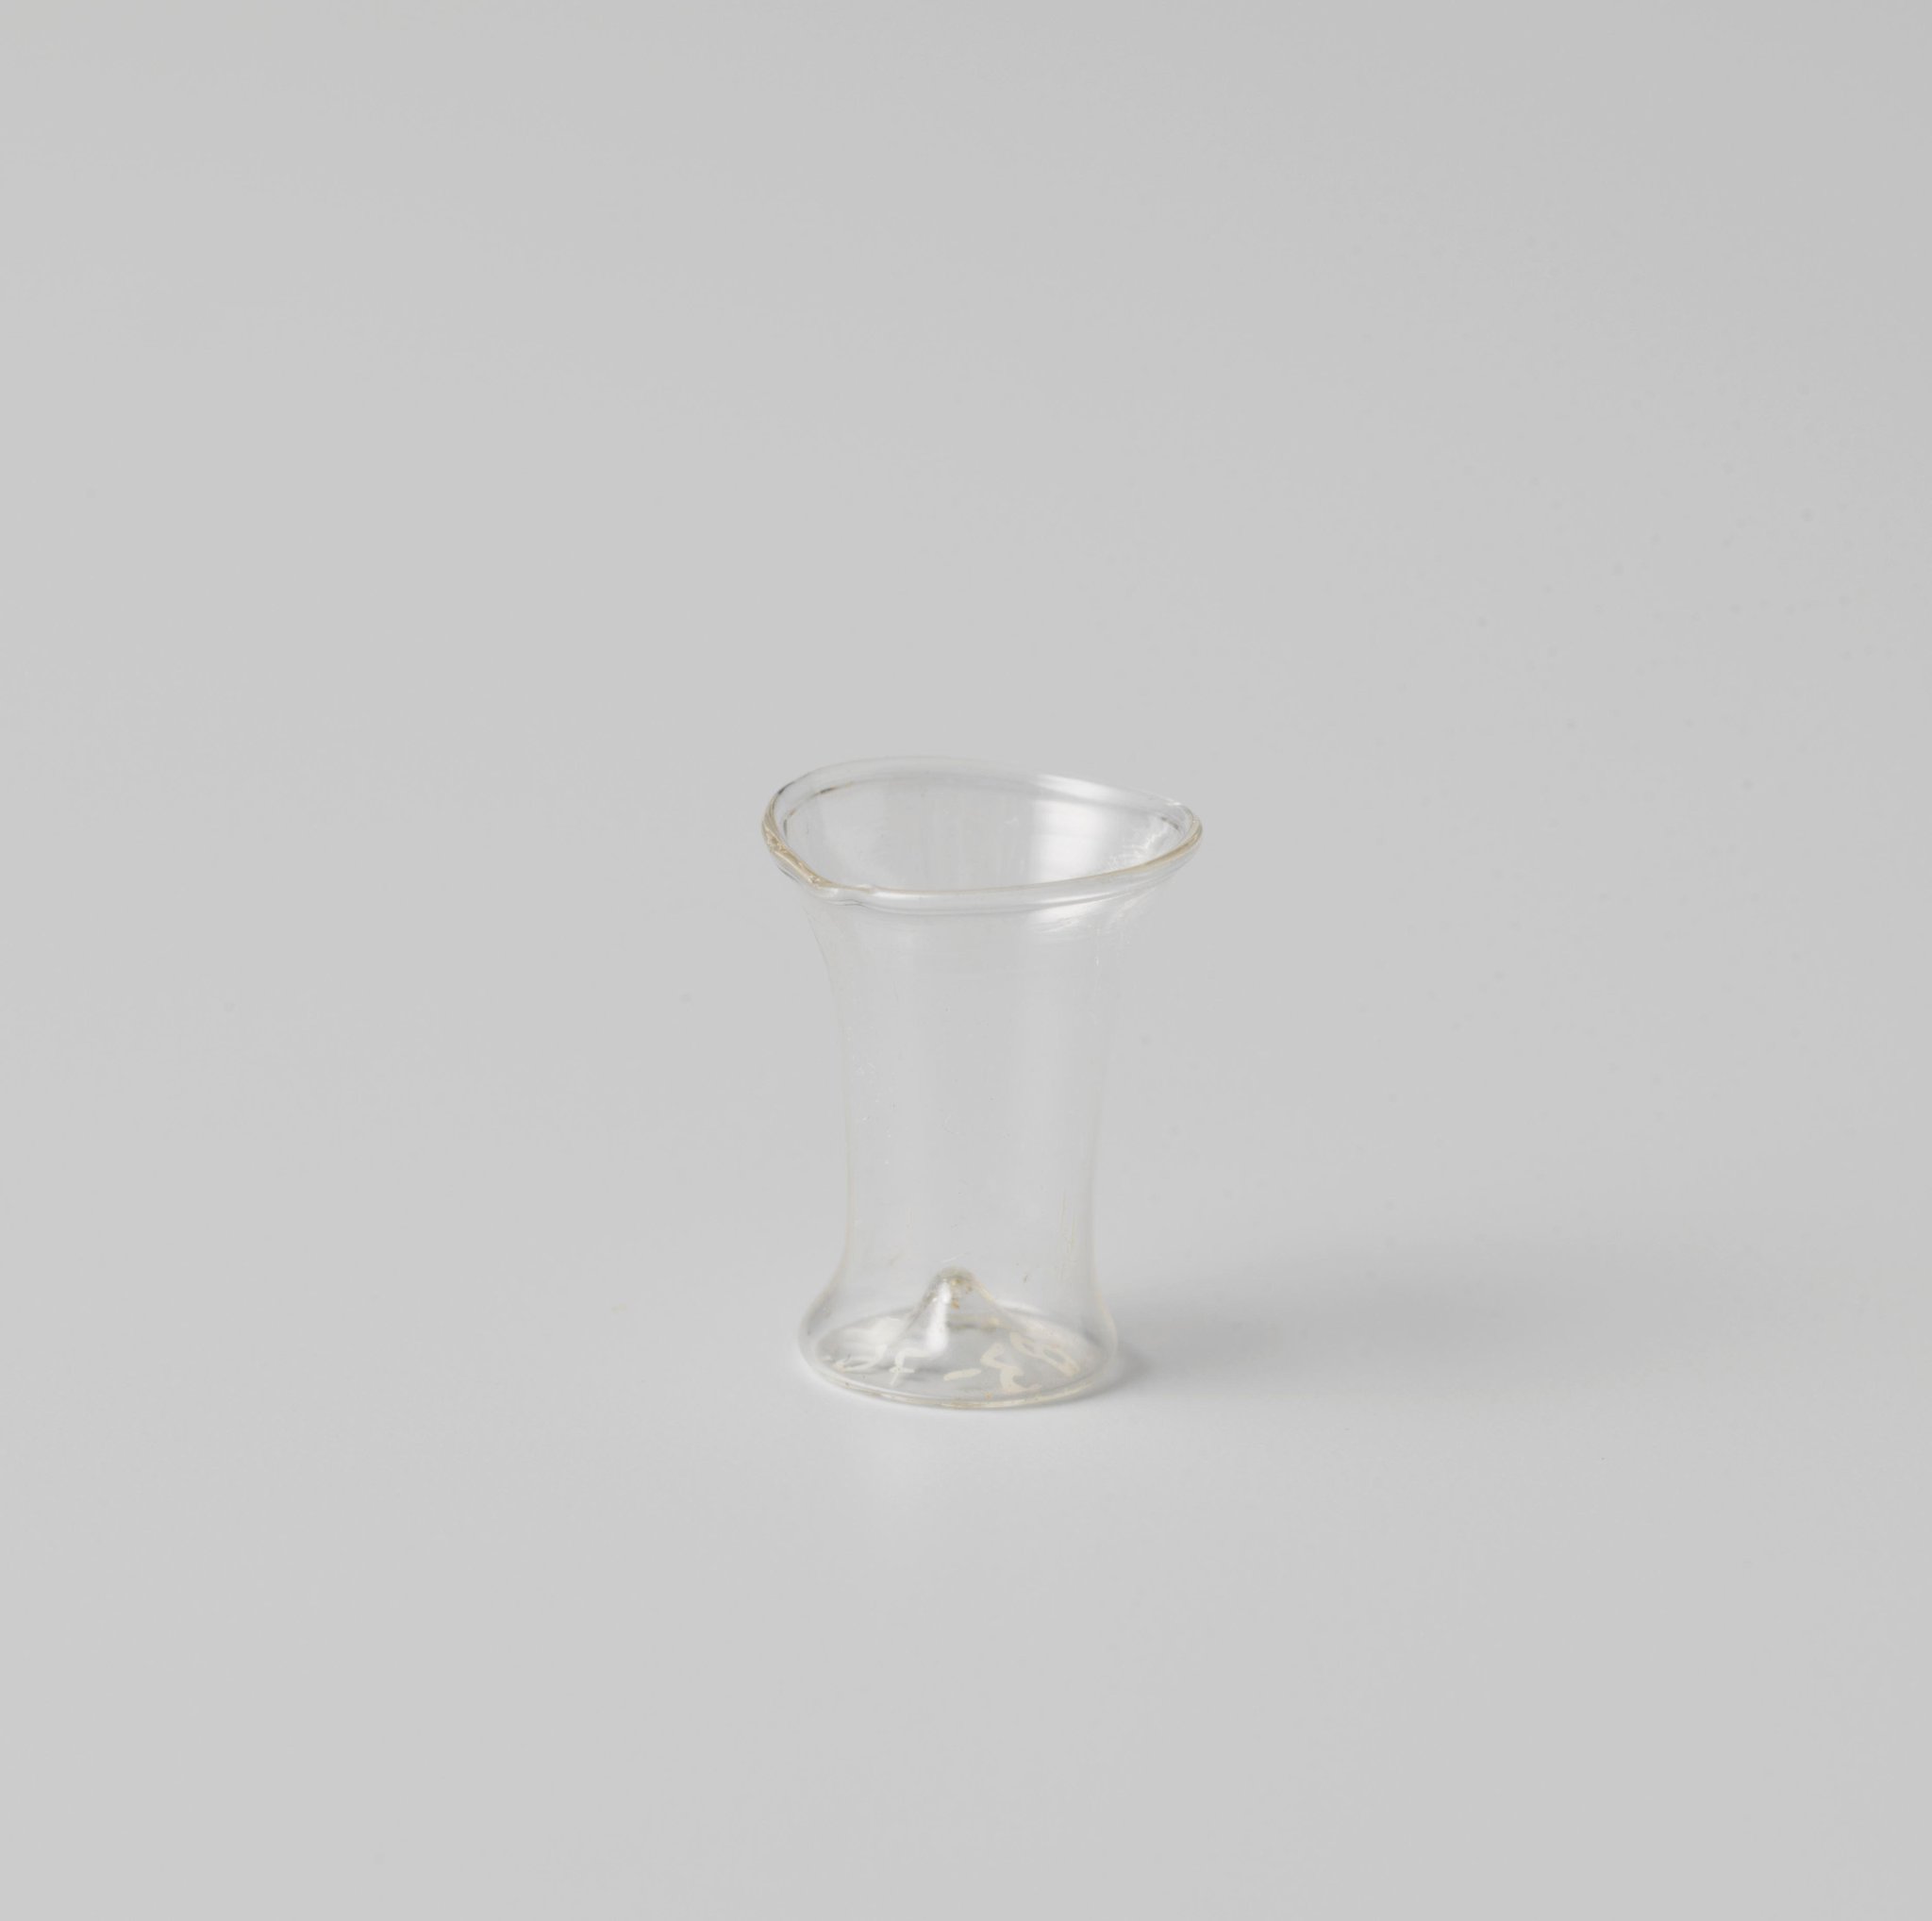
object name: miniature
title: Beker, zich naar boven toe verwijdend, met ingestoken bodem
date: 1675-1699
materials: glass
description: Beker van helder kleurloos glas, zich naar boven toe verwijdend, met ingestoken bodem.